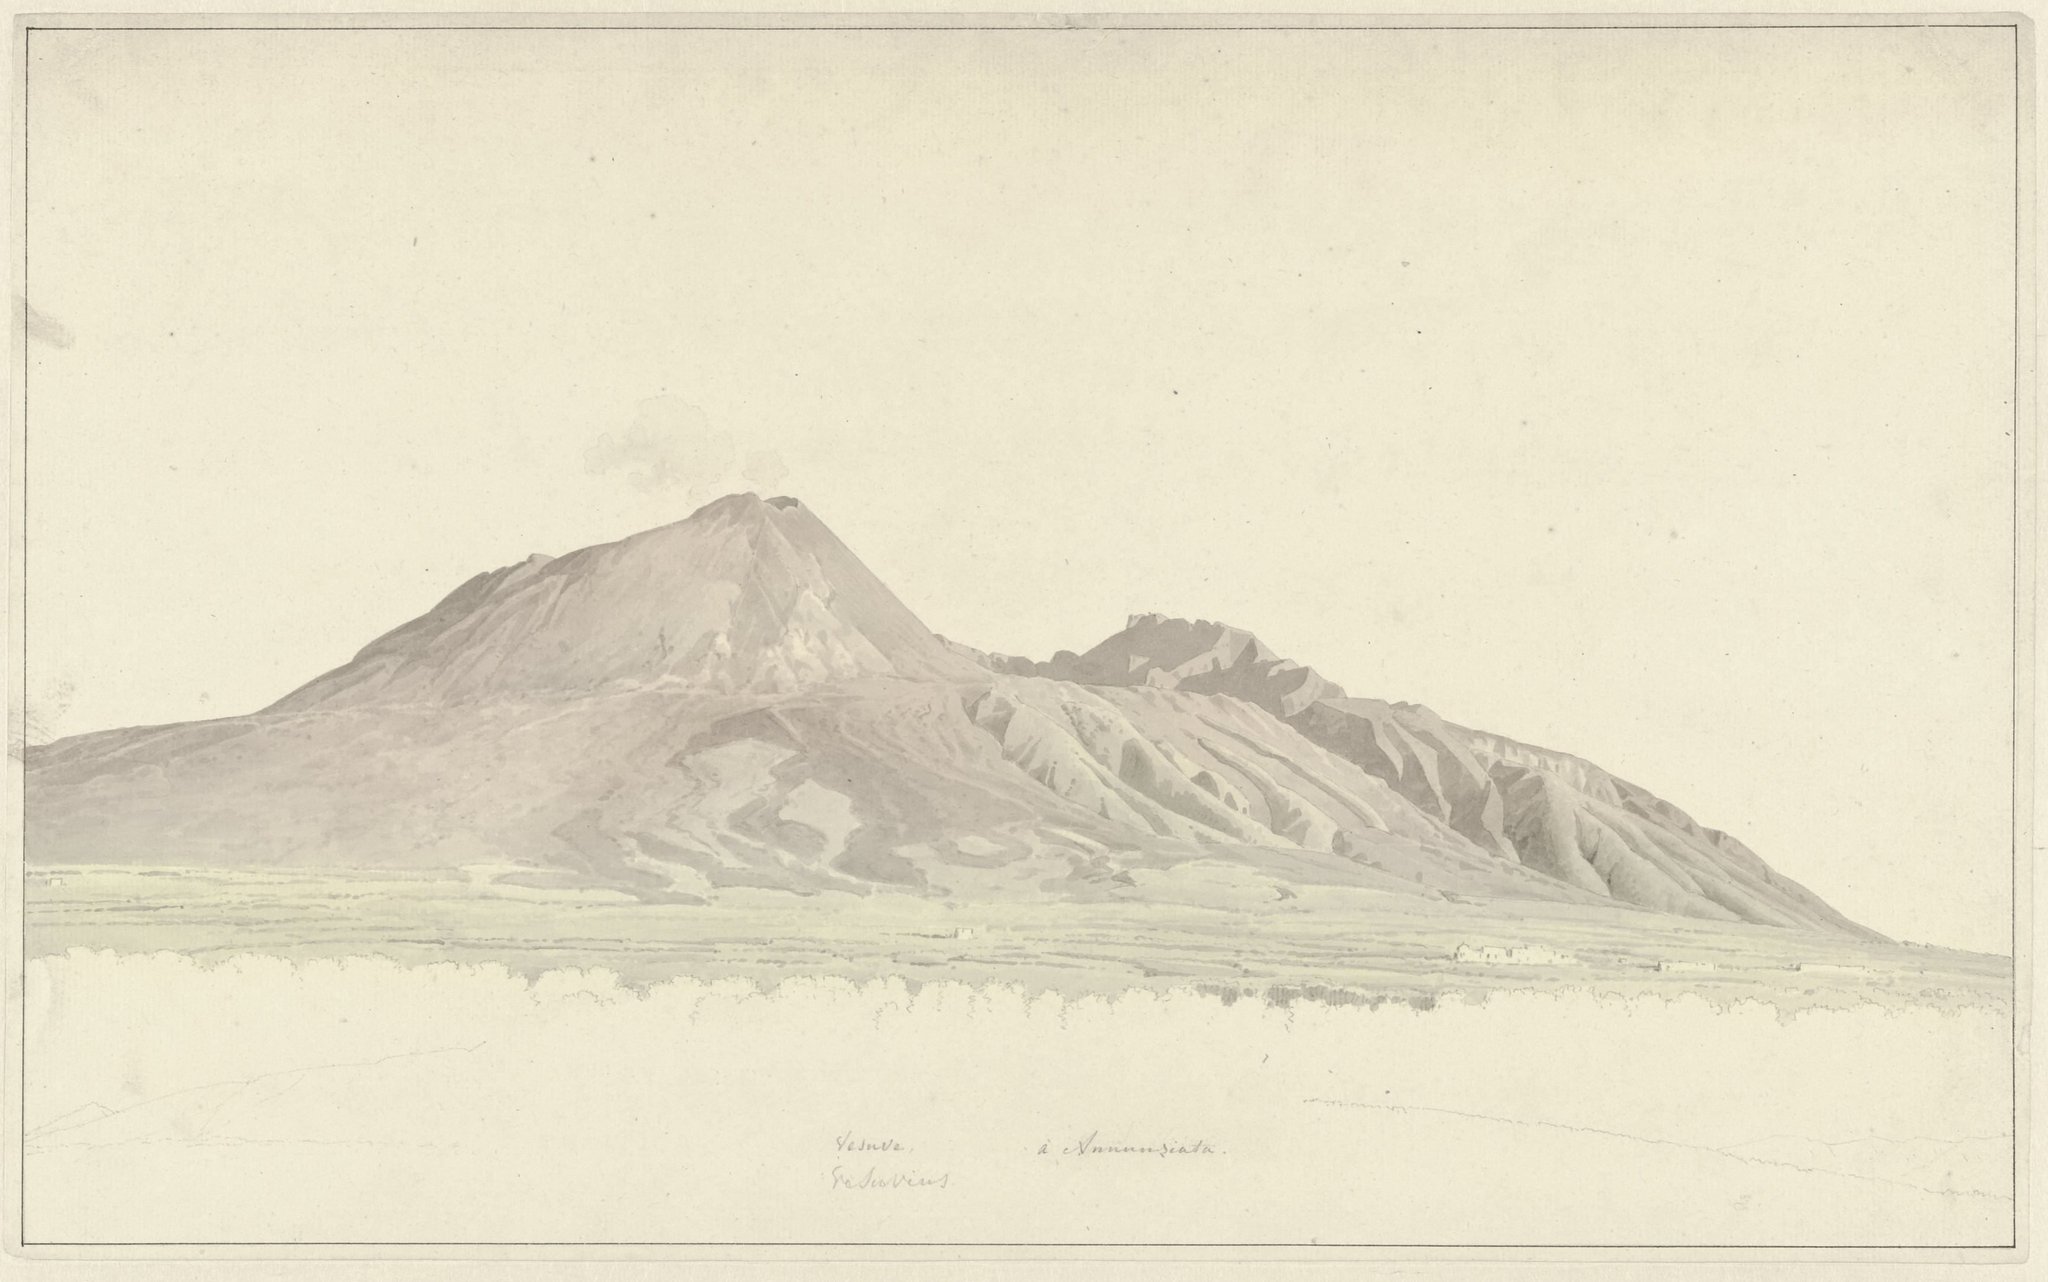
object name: drawing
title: A View of Mount Vesuvius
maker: josephus augustus knip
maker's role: draughtsman, painter, print maker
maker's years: 1777-1847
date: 1811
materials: graphite, paper, watercolor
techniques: brush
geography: italy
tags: volcano, mountains, mount vesuvius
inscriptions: inscription: ‘Vesuve / Vesuvius à Annunziata’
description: In a succinct biography of 1819 Knip wrote: ‘I set out for Naples on 6 September 1811, and having seen the most beautiful sights I returned to winter in Rome with a good portfolio (of drawings) from that beautiful region.’ He more than likely made his drawings of Mount Vesuvius on this trip. Vesuvius is still an active volcano. It erupted twice during Knip’s lifetime, in 1794 and 1826.